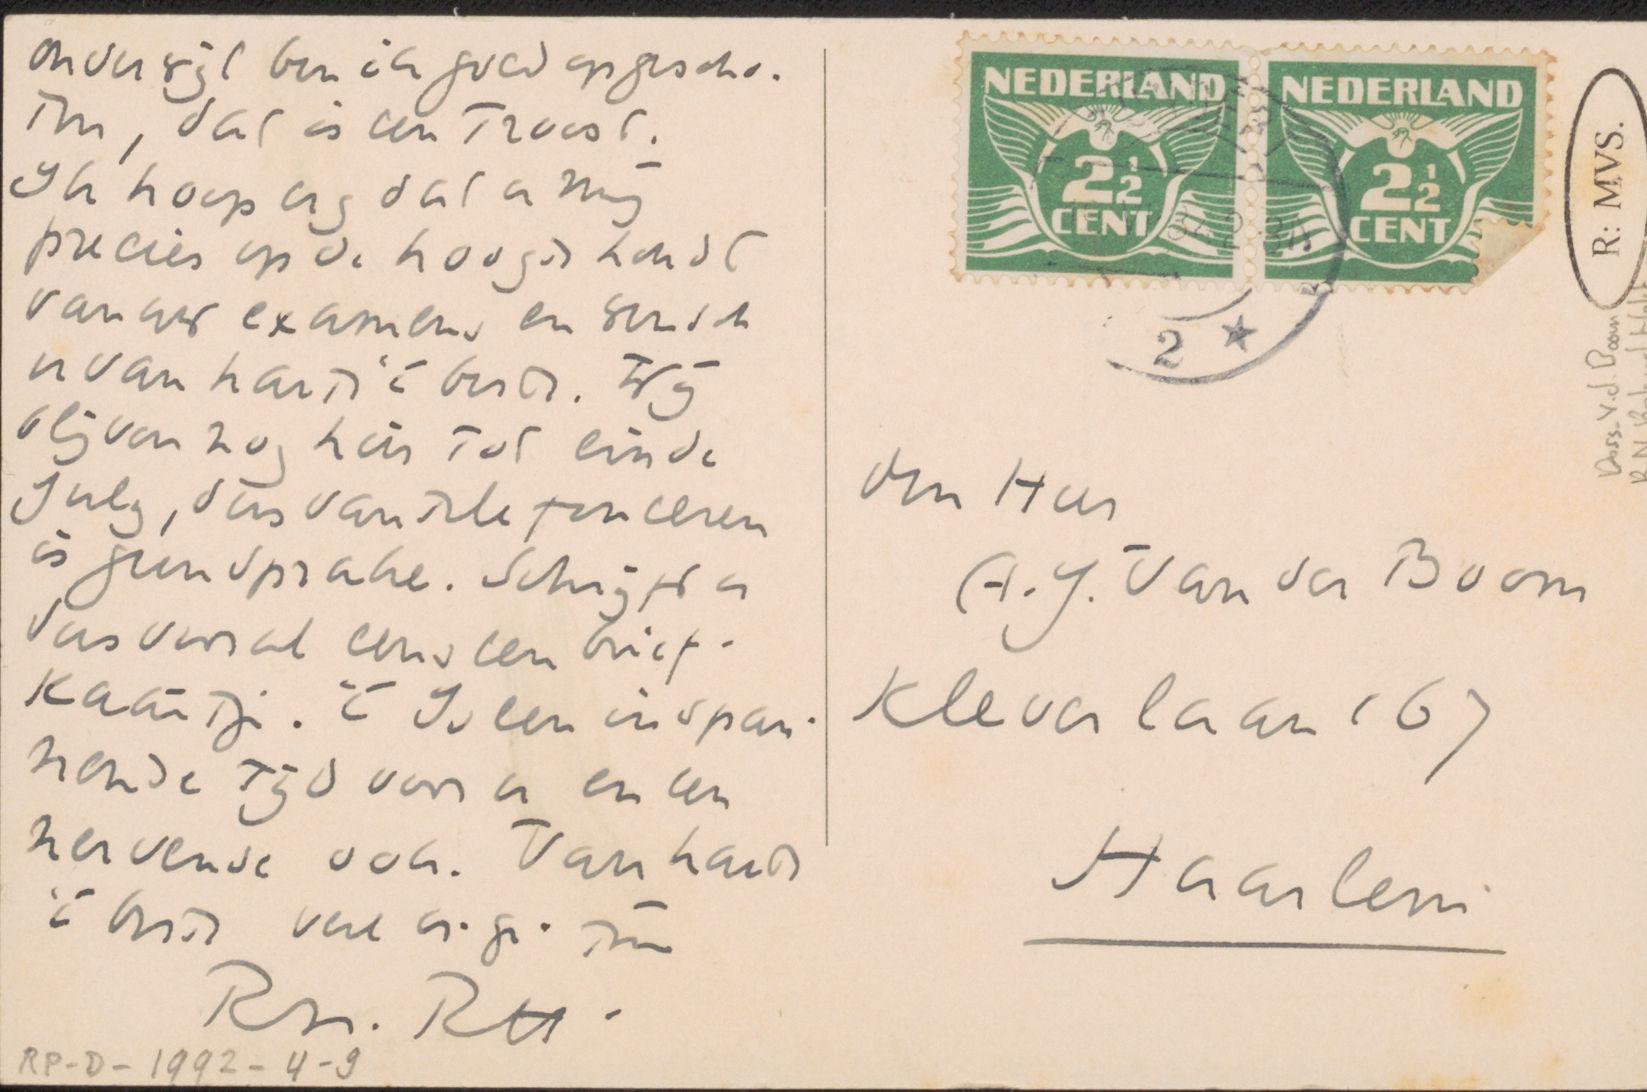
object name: ansichtkaart, prentbriefkaart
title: Prentbriefkaart aan A. van der Boom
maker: richard nicolaüs roland holst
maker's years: 1868-1938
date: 1925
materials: cardboard, ink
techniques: pen, writing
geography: buissche heide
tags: a. van der boom, diseases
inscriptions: collector's mark: Lugt L.2228a